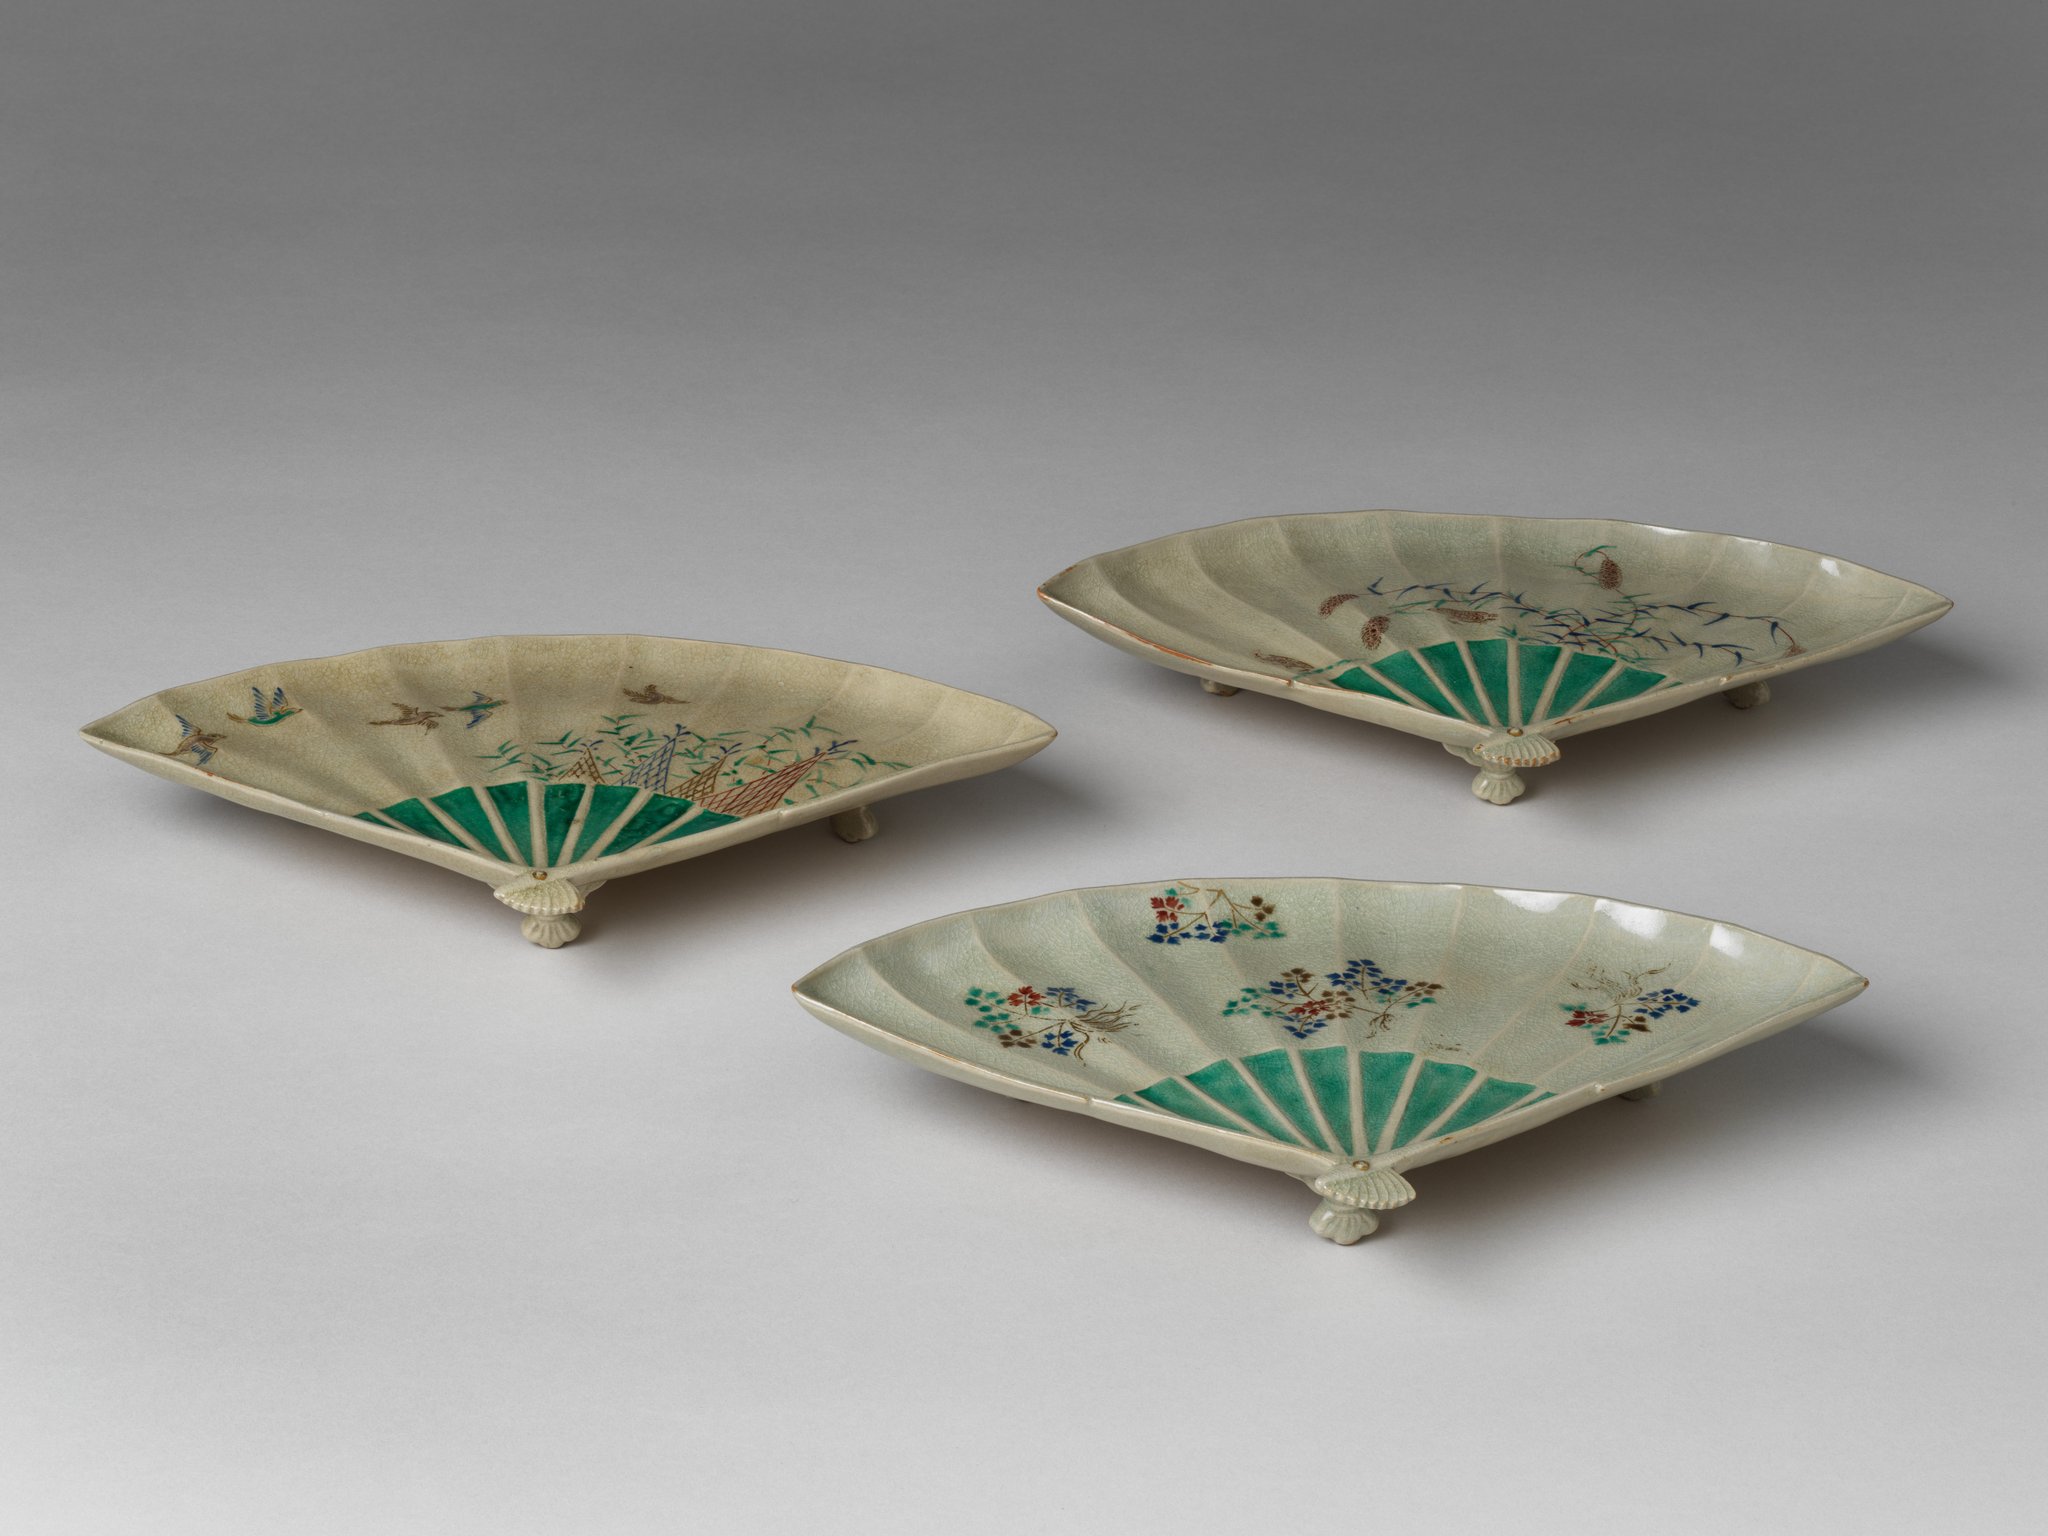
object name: dish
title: Set of three dishes in the shape of fans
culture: japanese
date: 1701-1733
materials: earthenware, glaze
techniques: polychrome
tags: fans